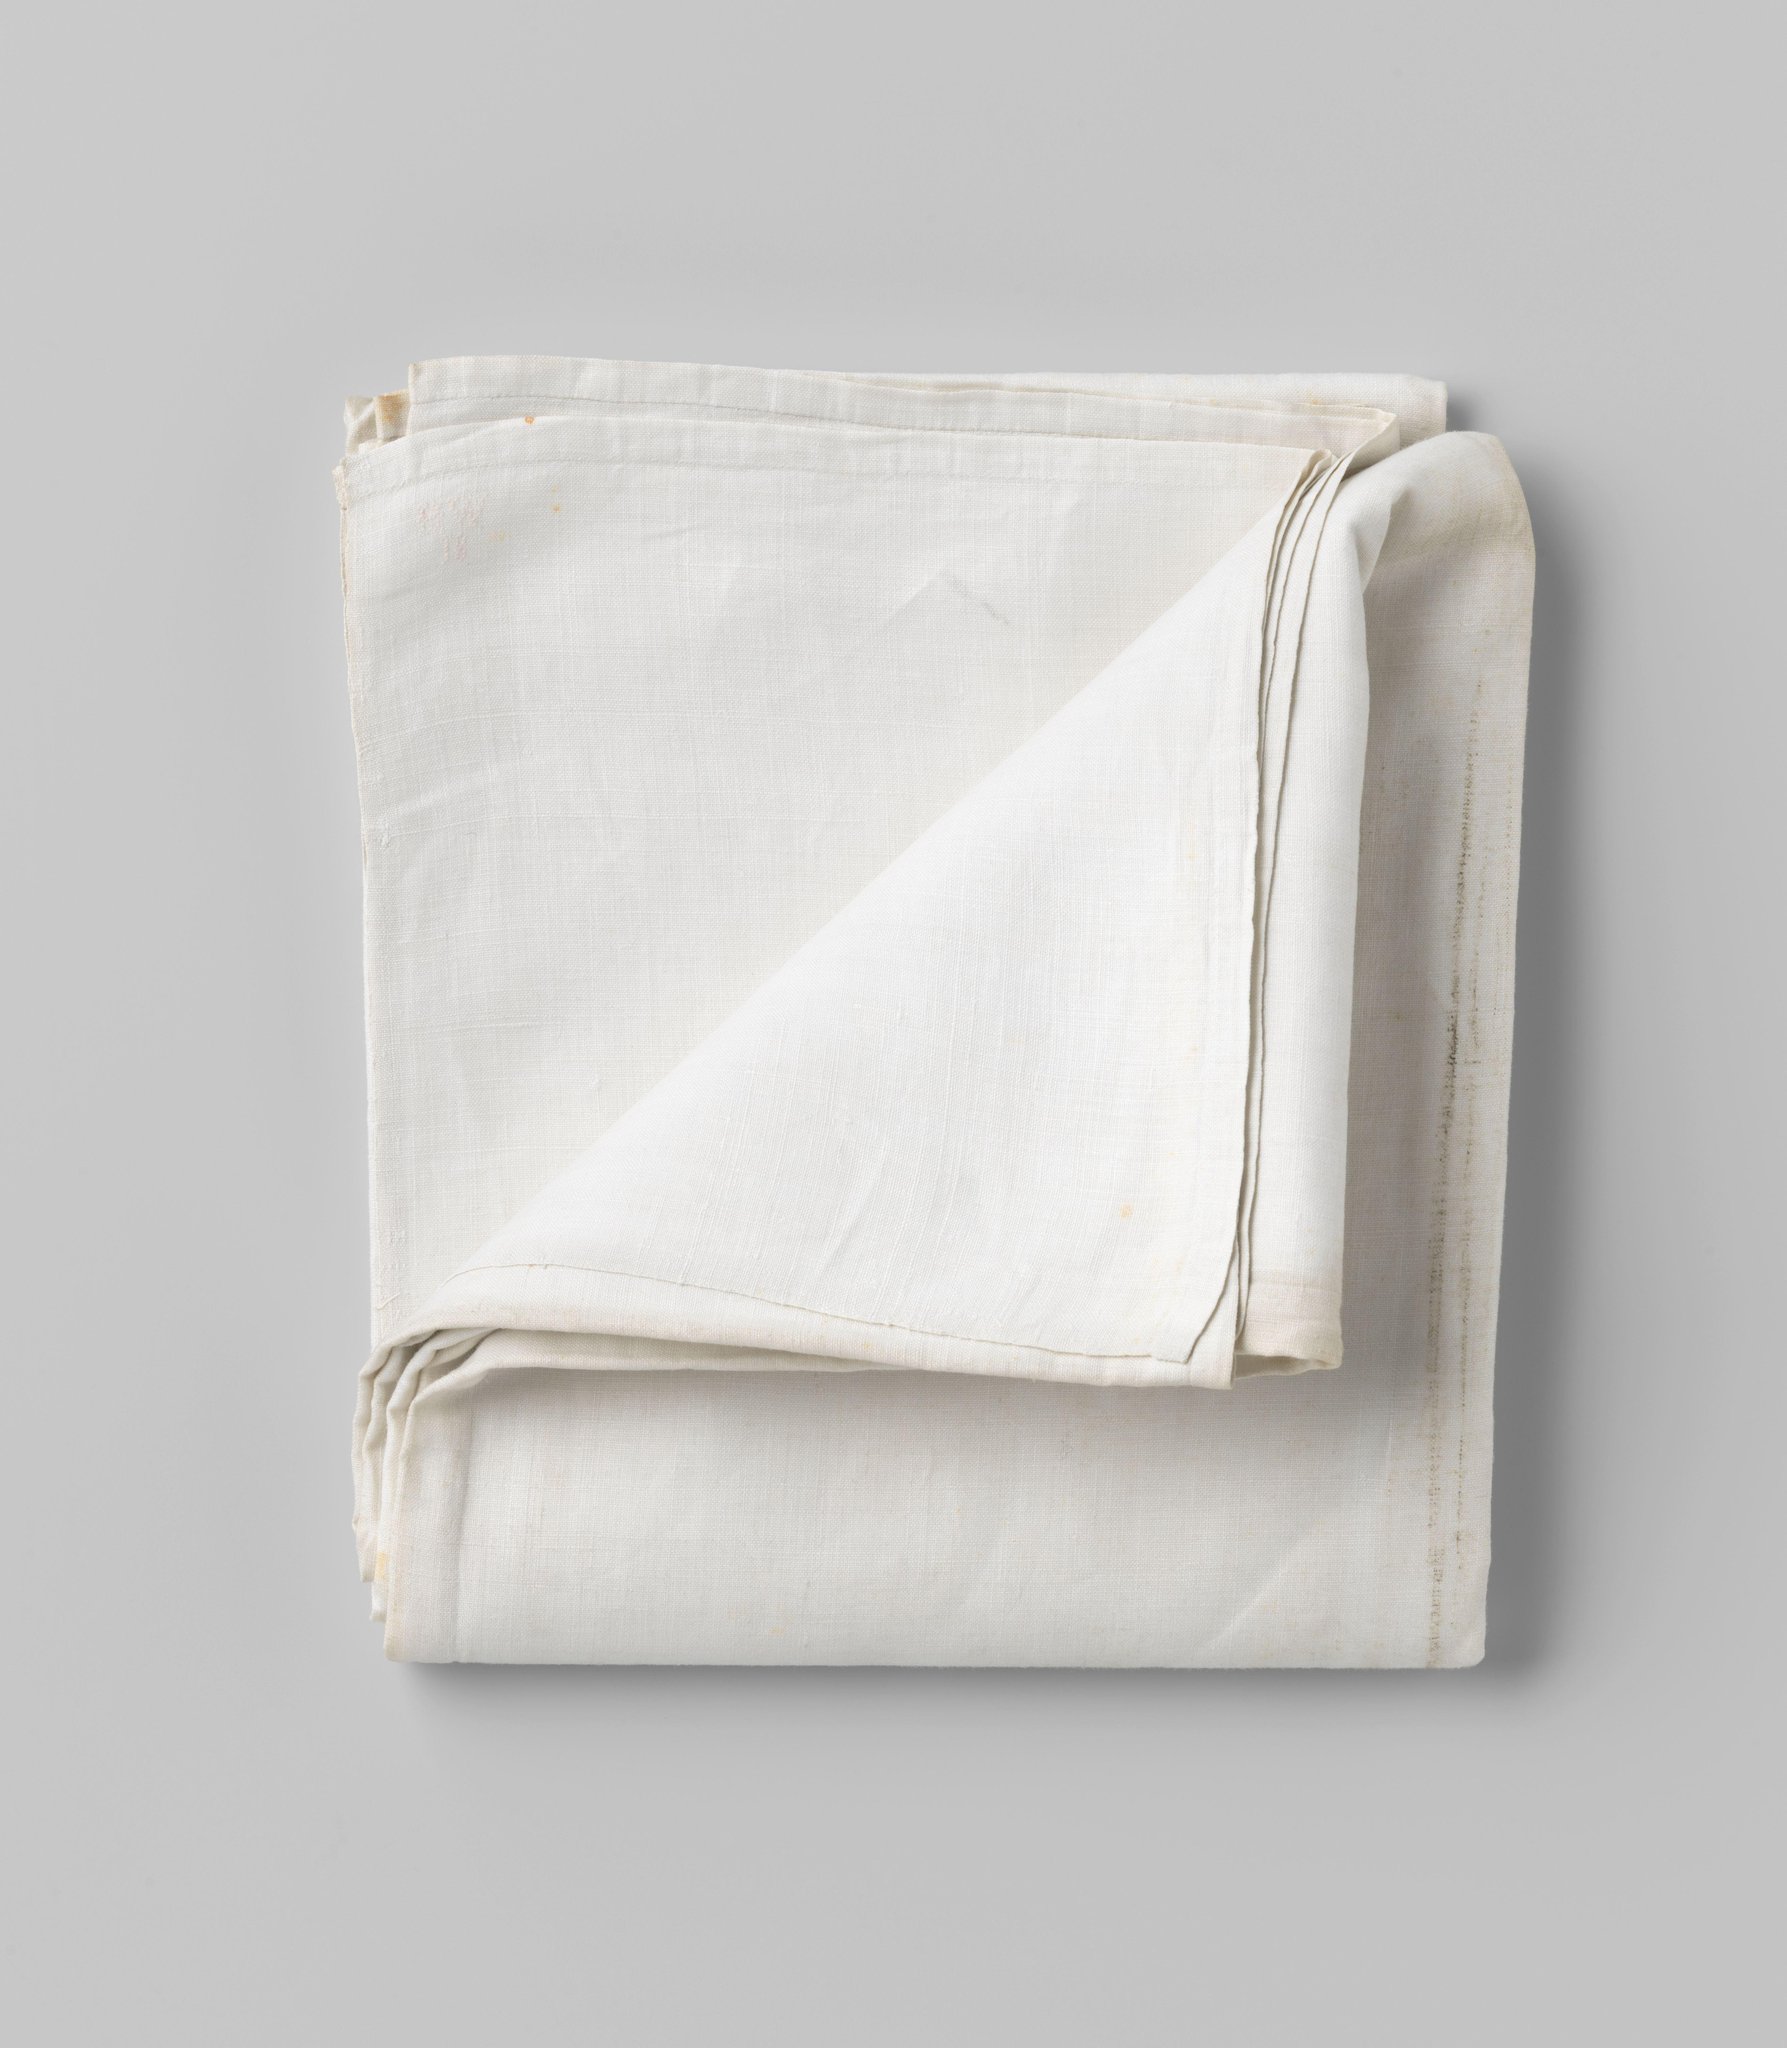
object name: beddenlaken, laken object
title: Laken. Merk: W18.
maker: Anonymous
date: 1855-1870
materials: linen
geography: northern netherlands